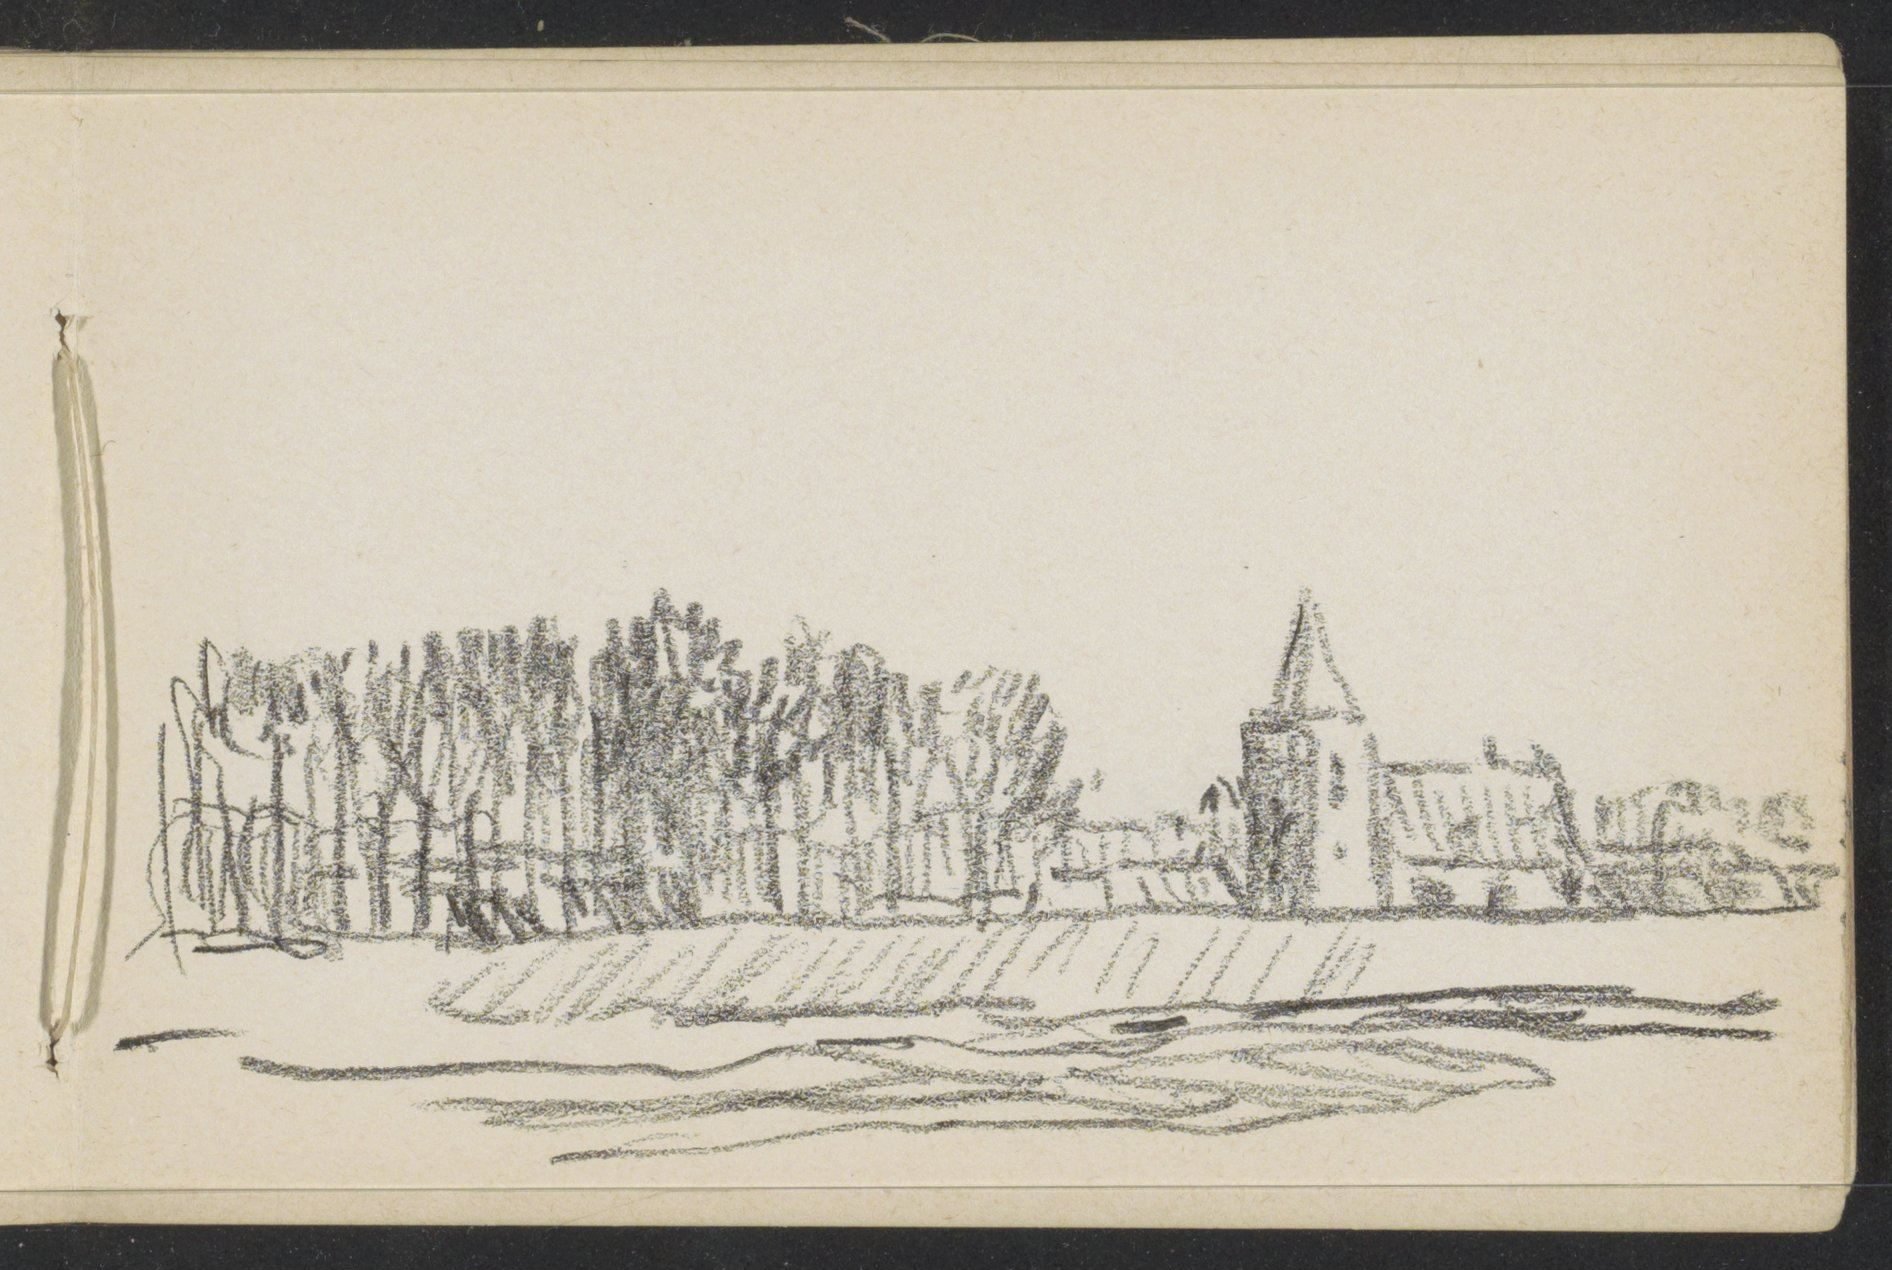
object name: sketchbook leaf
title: Gezicht op Veere met de Campveerse Toren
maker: alexander shilling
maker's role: draughtsman, print maker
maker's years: 1859-1937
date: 1910-1923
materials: chalk, paper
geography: veere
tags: towers ~ fortified city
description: Blad 22 recto uit een schetsboek met 26 bladen.